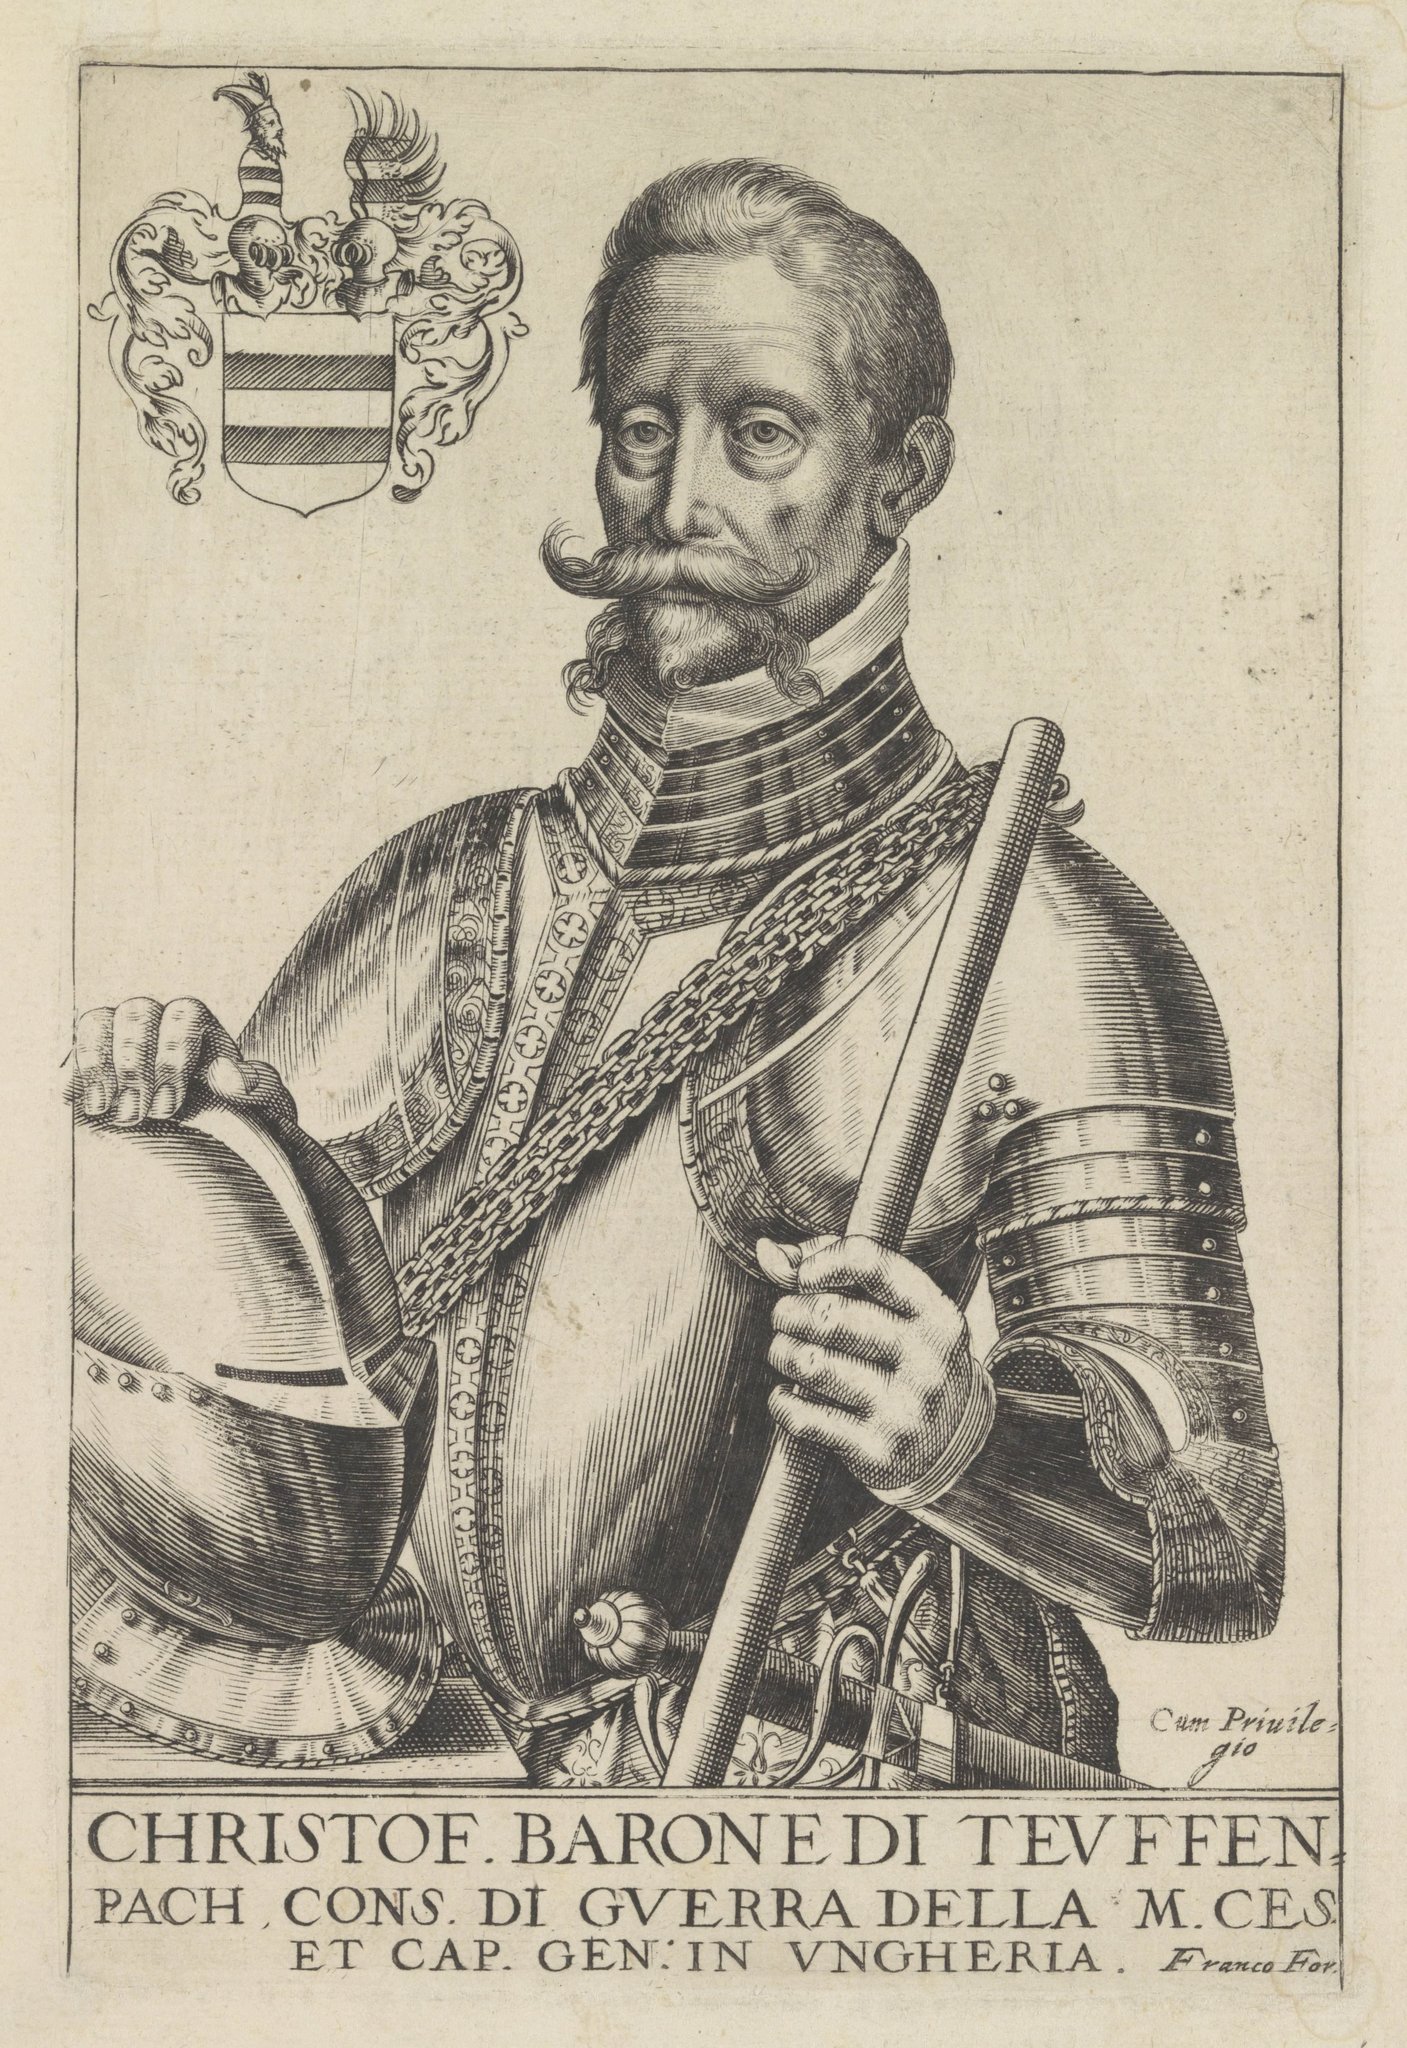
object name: print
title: Portret van Christoph von Teuffenbach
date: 1560-1620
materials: paper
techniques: engraving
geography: italy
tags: prague, historical persons, ruler, sovereign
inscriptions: collector's mark: Lugt 2228